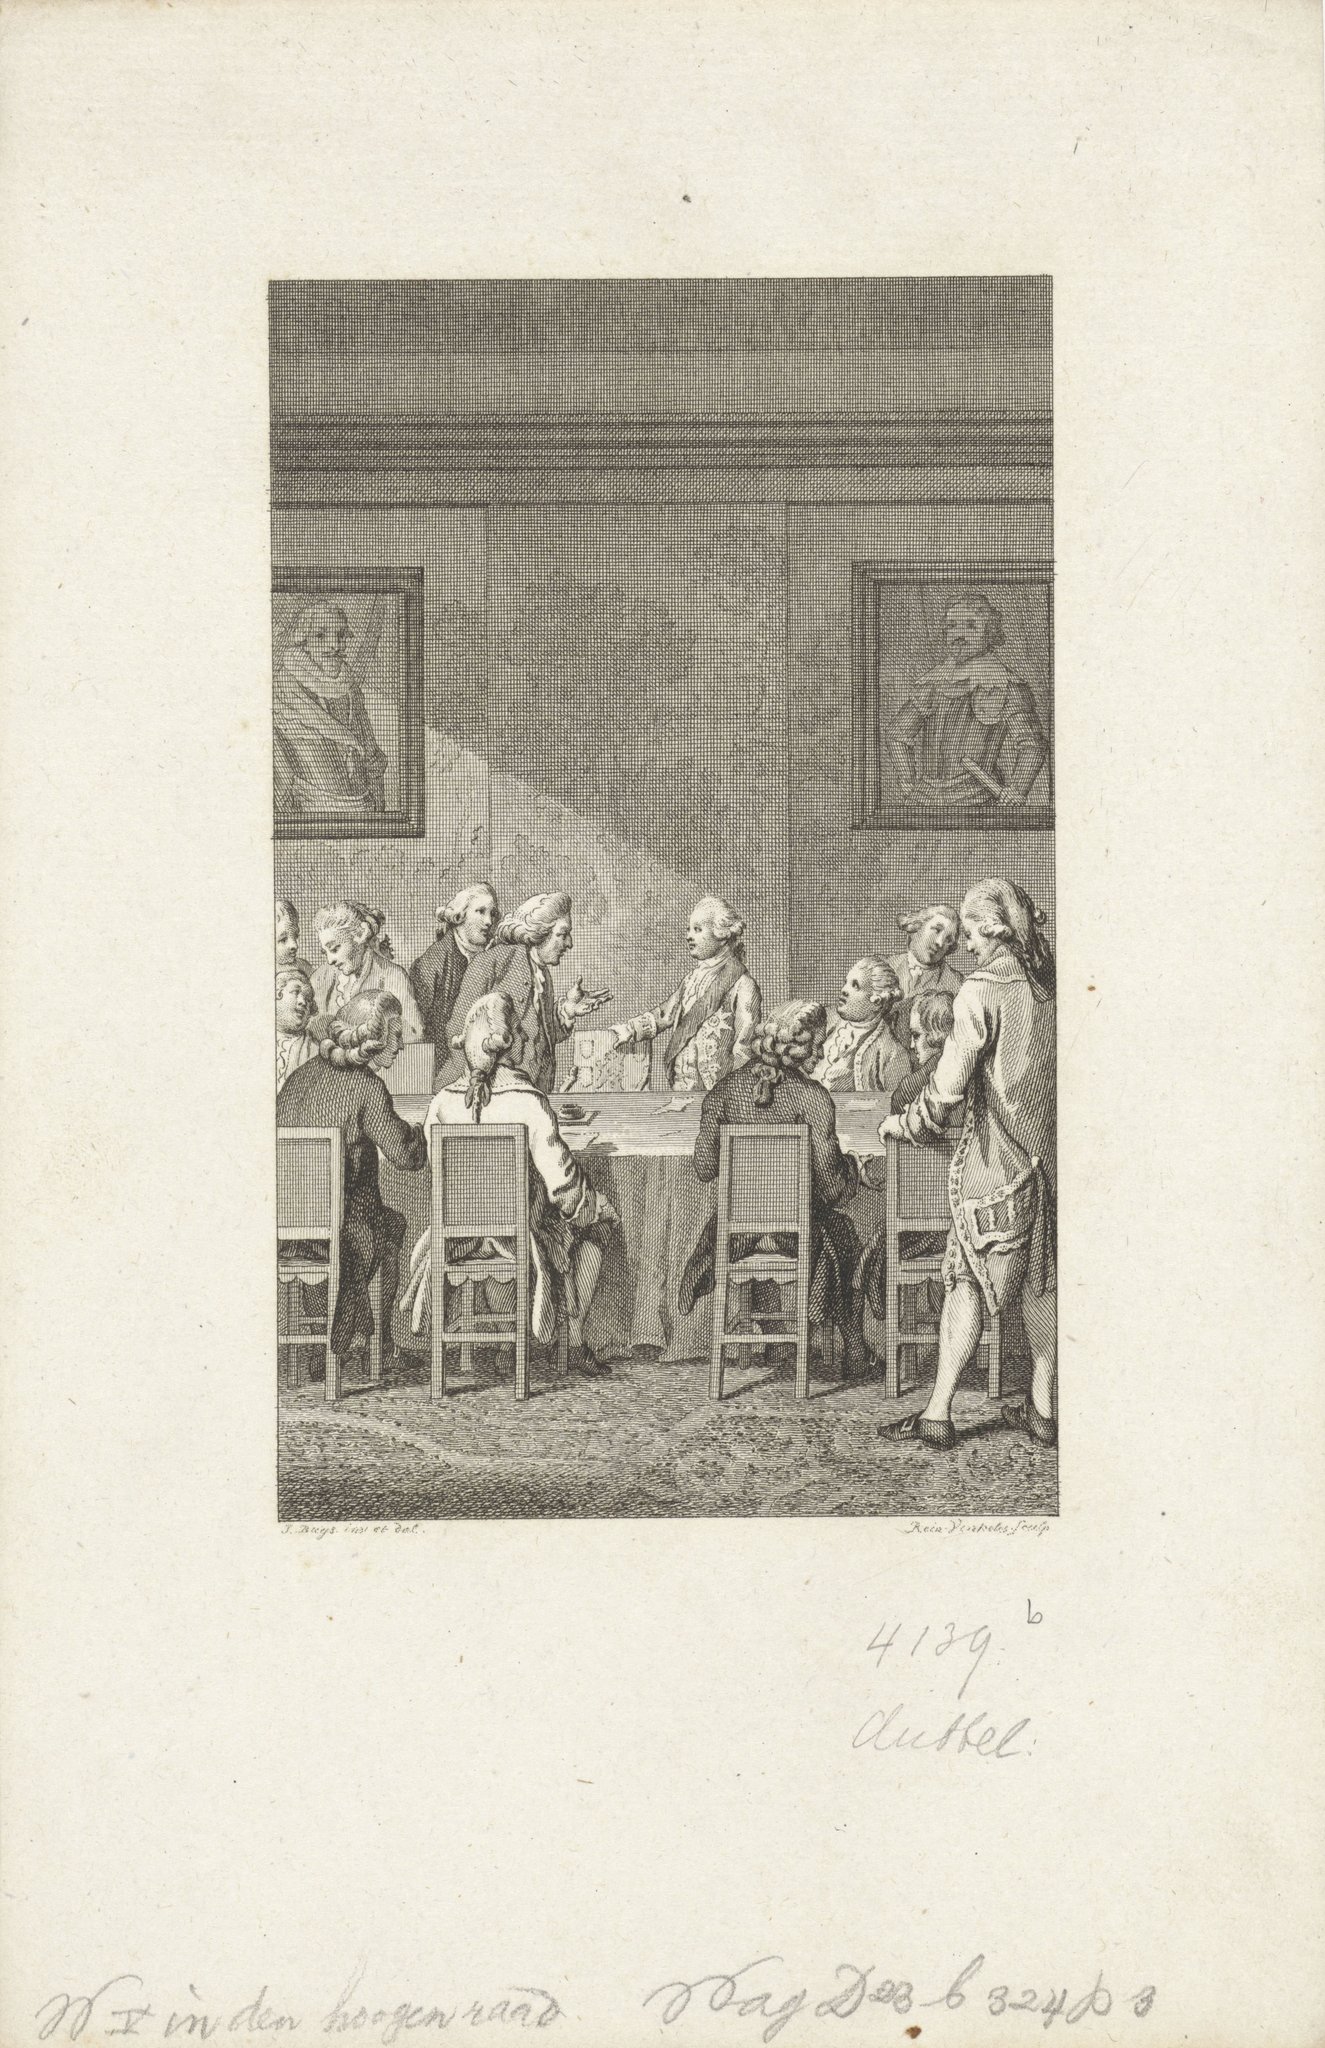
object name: print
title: Willem V neemt voor het eerst zitting in de Raad van State, 1763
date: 1795-1797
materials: paper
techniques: engraving, etching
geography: amsterdam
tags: the hague, william v (prince of orange), national government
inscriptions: collector's mark: Lugt 2228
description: Gebruikt als illustratie in: P.A. Loosjes. Vaderlandsche historie, vervattende de geschiedenissen, der Vereenigde Nederlanden (...). Drie-en-twintigste deel. Beginnende met den jaare 1759 en eindigende met den jaare 1765, bevattende het tydperk der minderjaarigheid des erfstadhouders Willem den V. Ten onmiddelyken vervolge van Wagenaar's Vaderlandsche historie. Amsterdam: J. Allart, 1797.